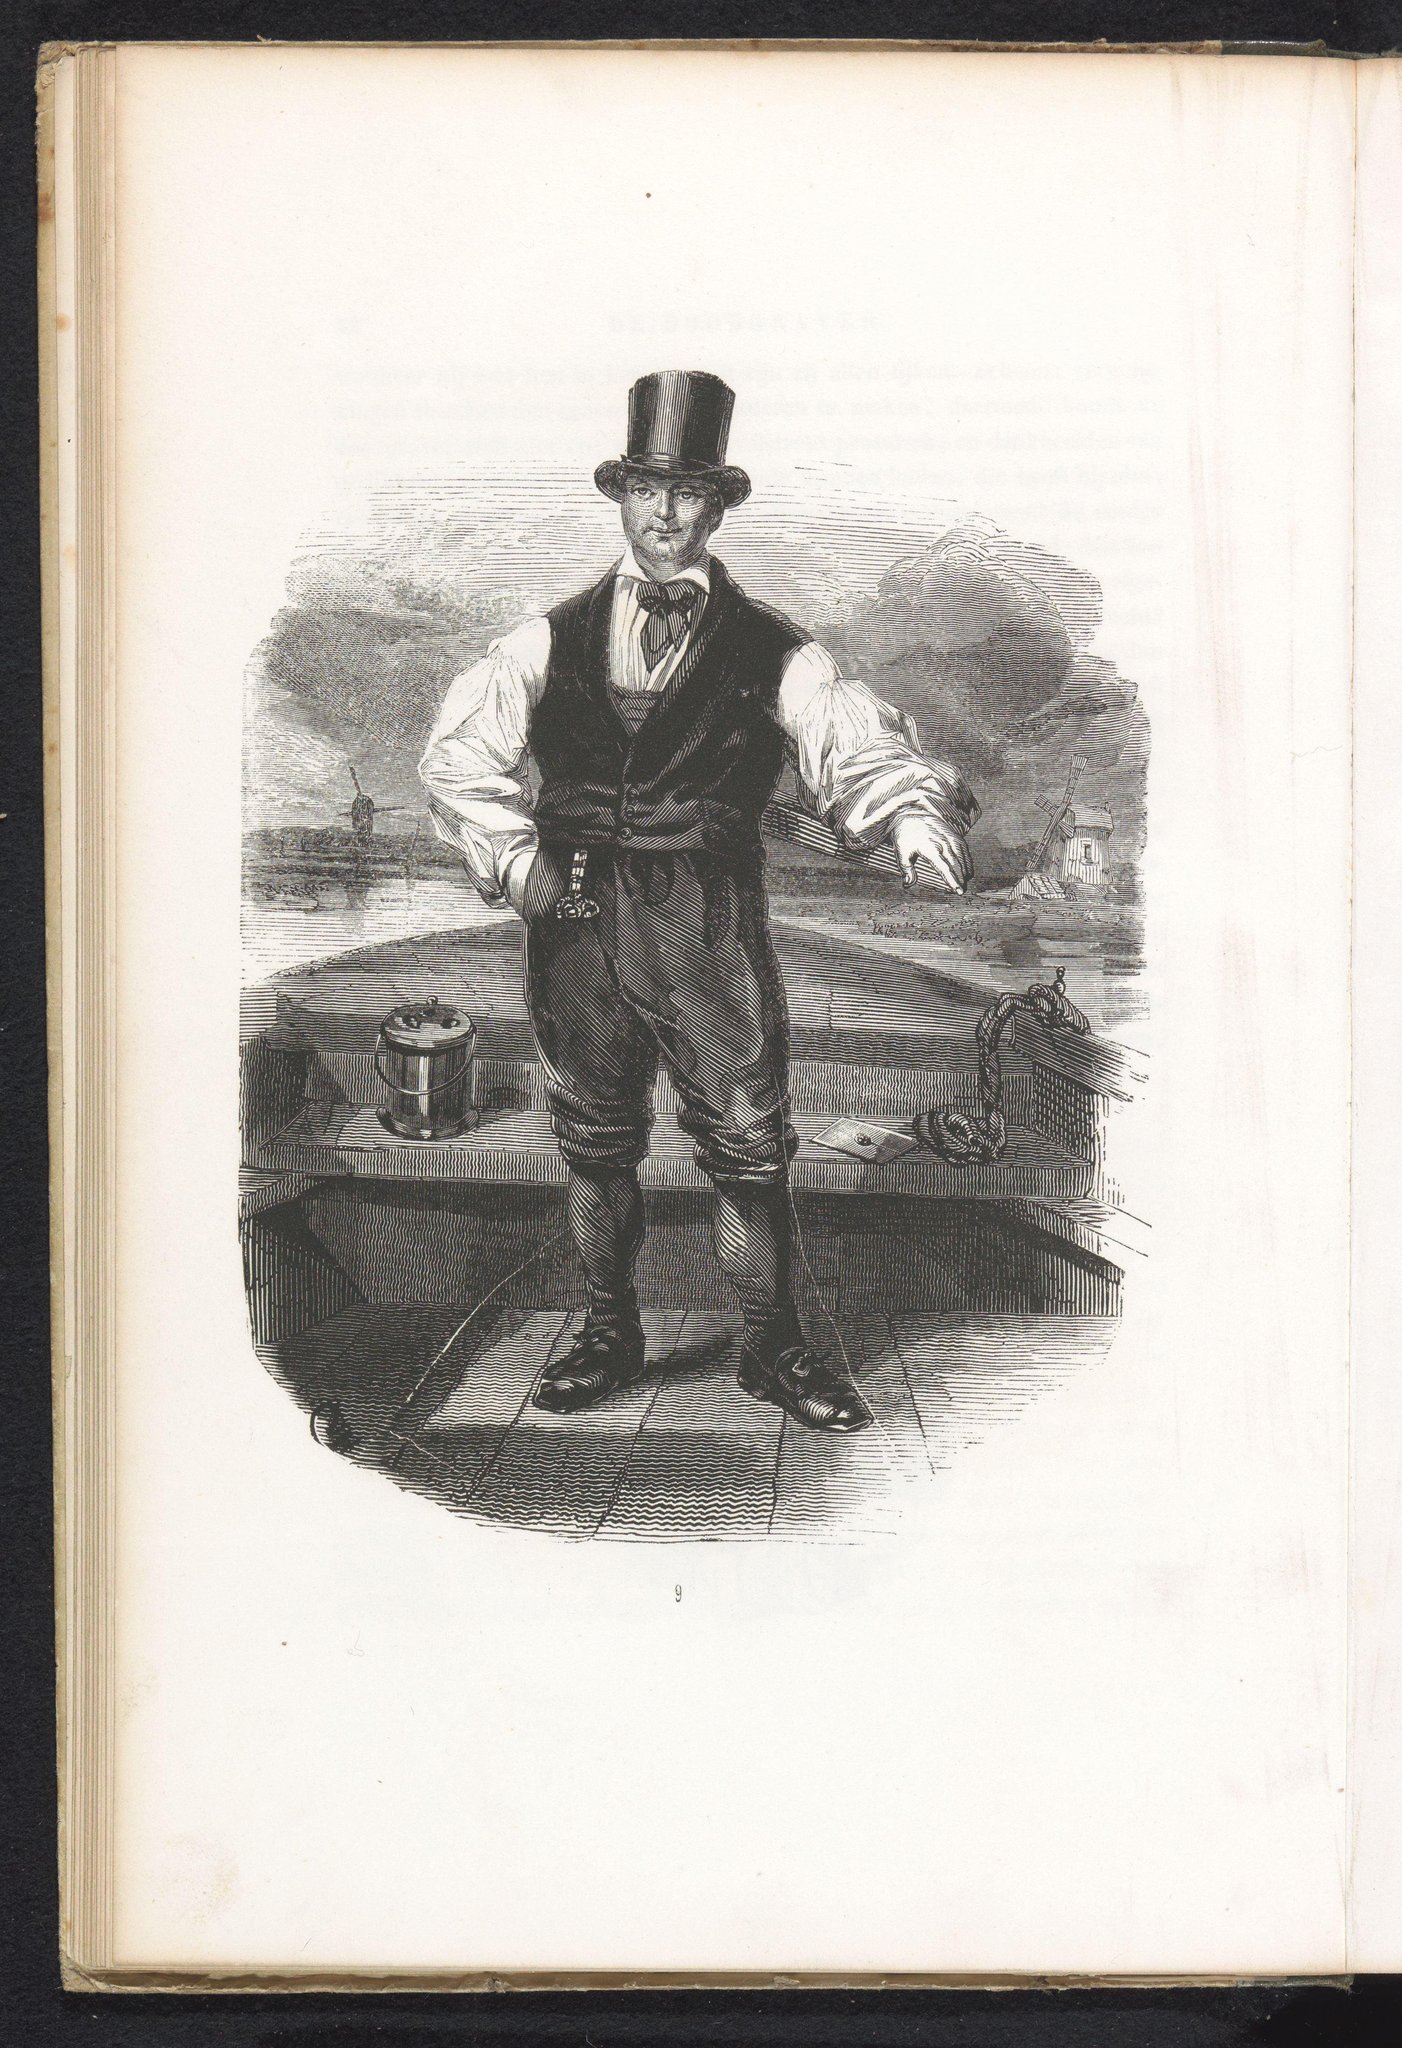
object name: print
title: De veerschipper, 1840-1841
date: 1841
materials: paper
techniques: letterpress printing, engraving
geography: the hague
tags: crew ~ ship, professional clothes, ferry, netherlands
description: De veerschipper. Staande man aan de roer van een veerboot..Genummerd: 9. Illustratie in het boek 'De Nederlanden: karakterschetsen, kleederdrachten, houding en voorkomen van verschillende standen', een boek met karakterschetsen, beroepen en klederdrachten van Nederlandse volkstypen uit 1841.